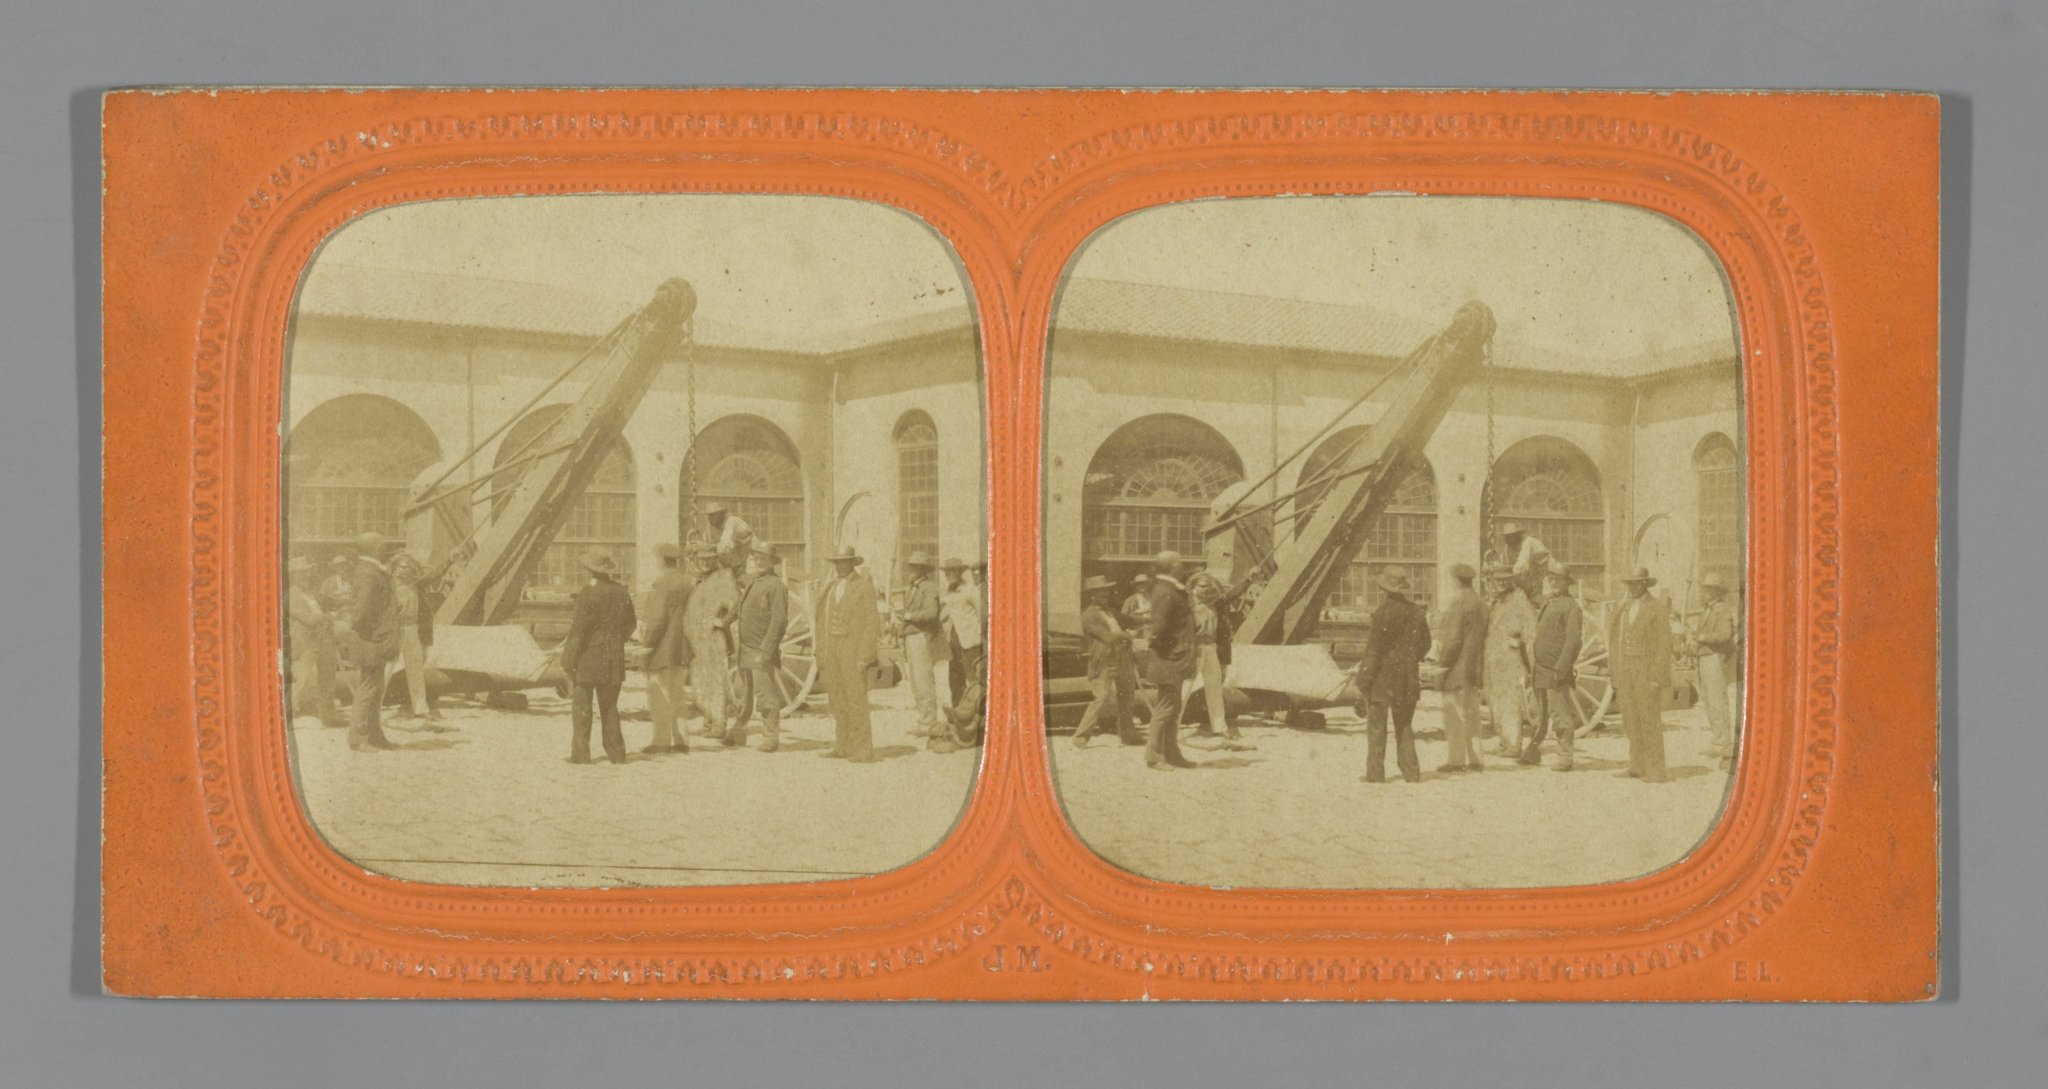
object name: tissue stereograph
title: Arbeiders bij hijskraan voor fabriek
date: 1855-1875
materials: cardboard, paper, photographic support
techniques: albumen print, hand coloring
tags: vertical transport, hoisting (industrial processes)